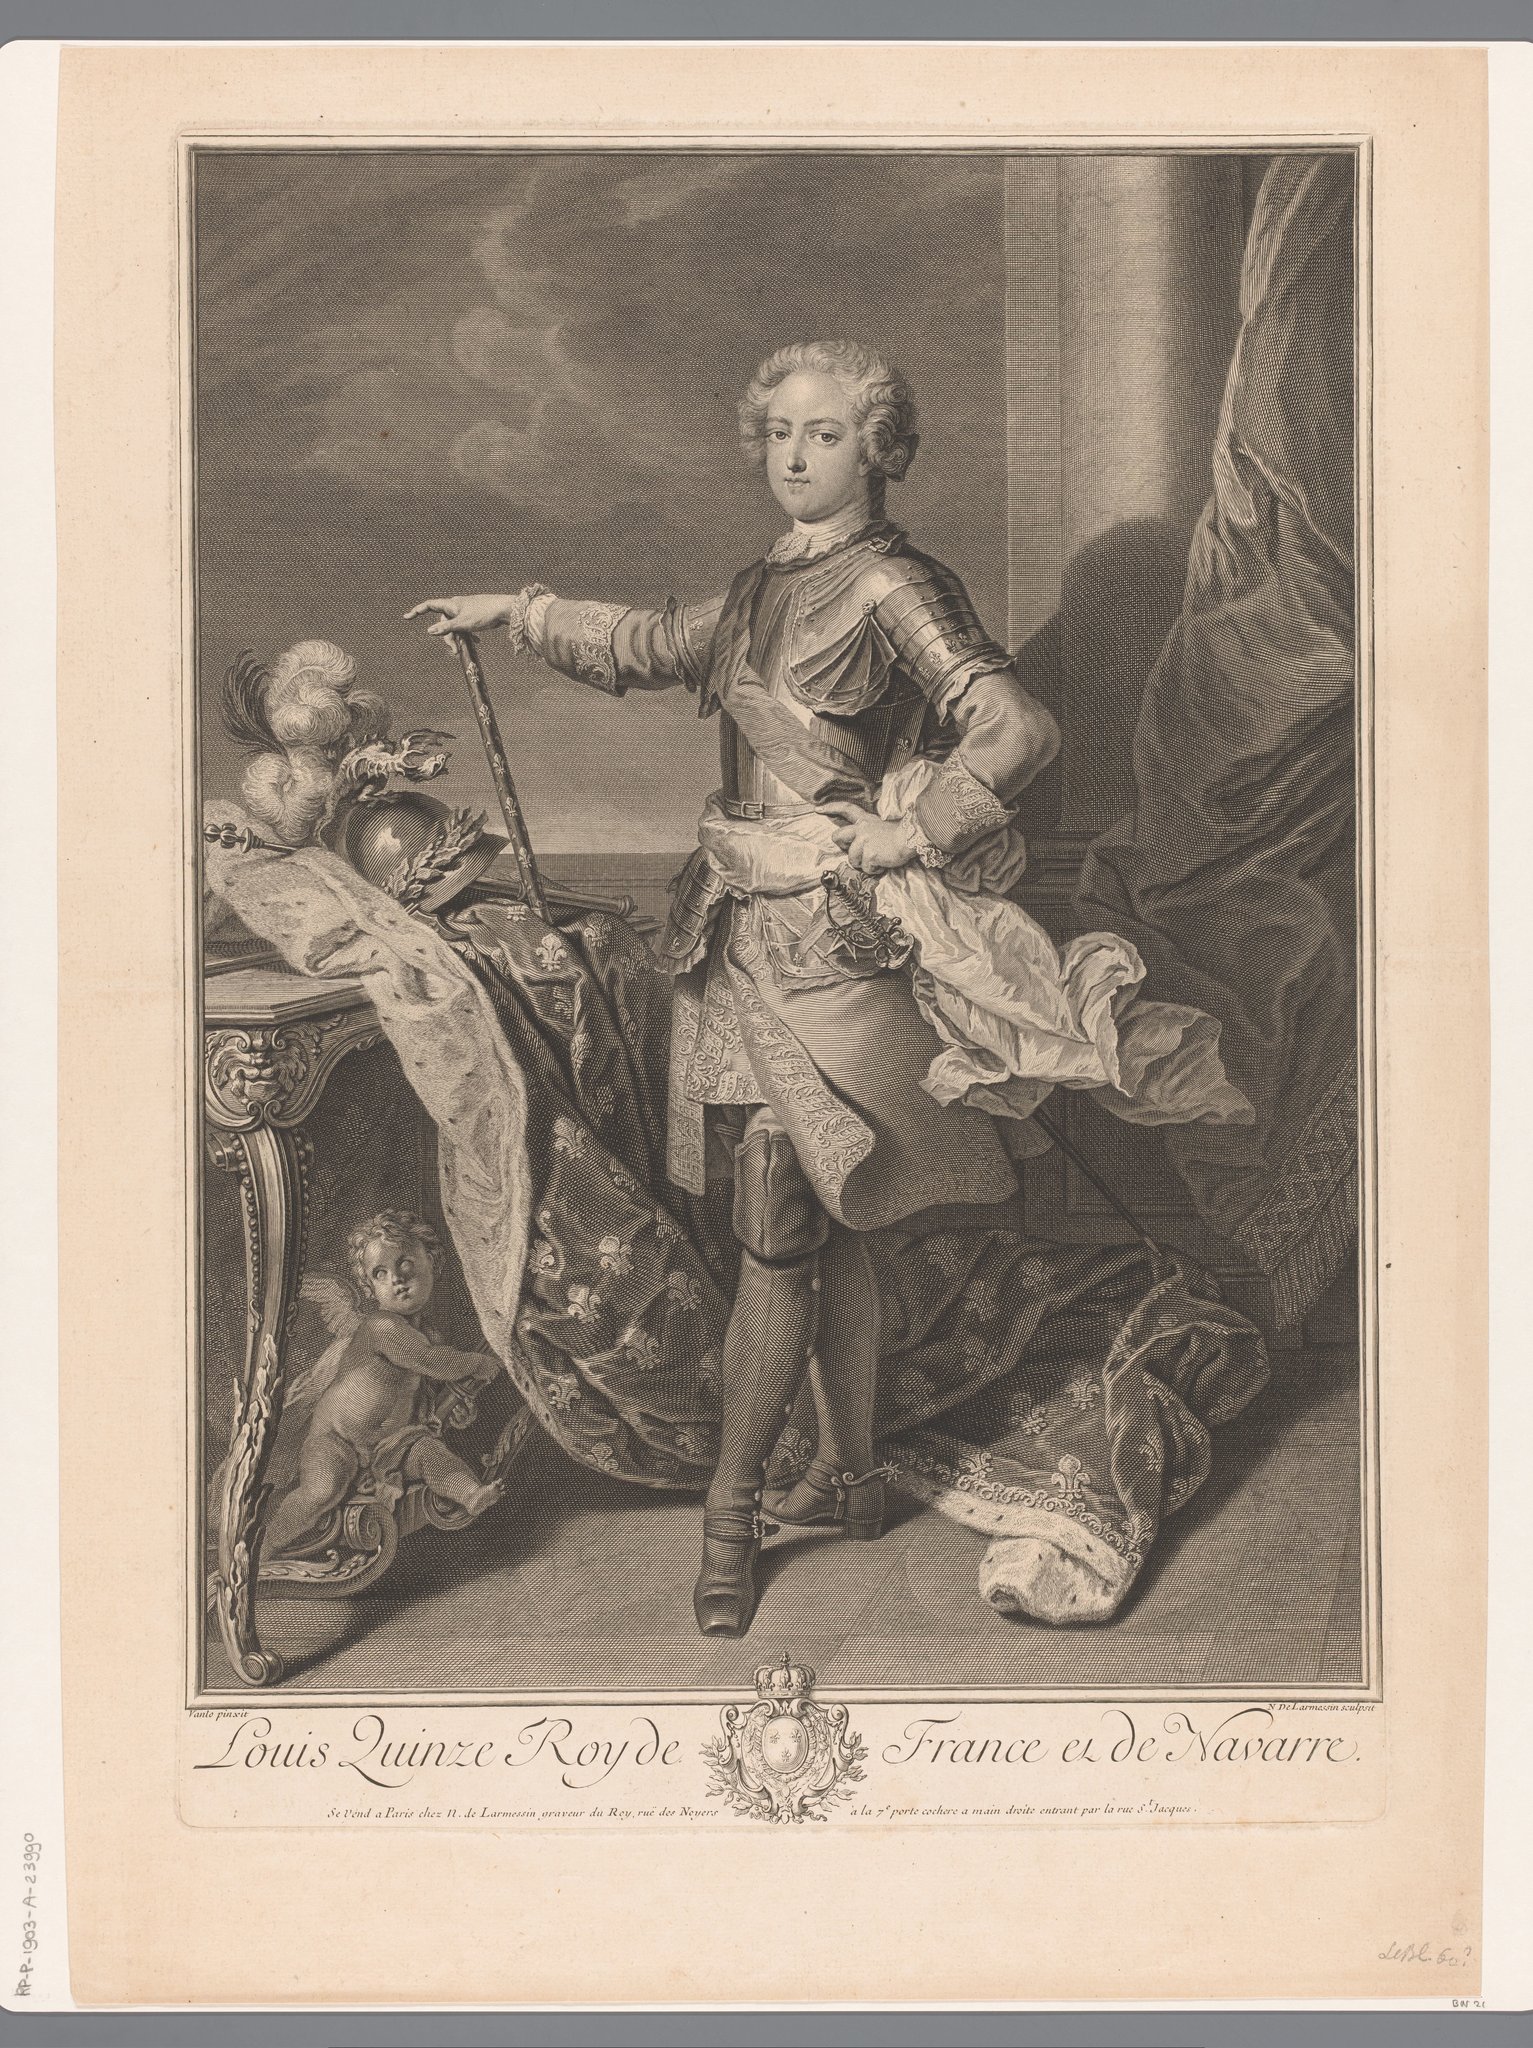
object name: print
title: Louis Quinze Roy de France et de Navarre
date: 1727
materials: paper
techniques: engraving, etching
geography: paris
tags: louis xv of france, historical persons, king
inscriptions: collector's mark: Lugt 2228